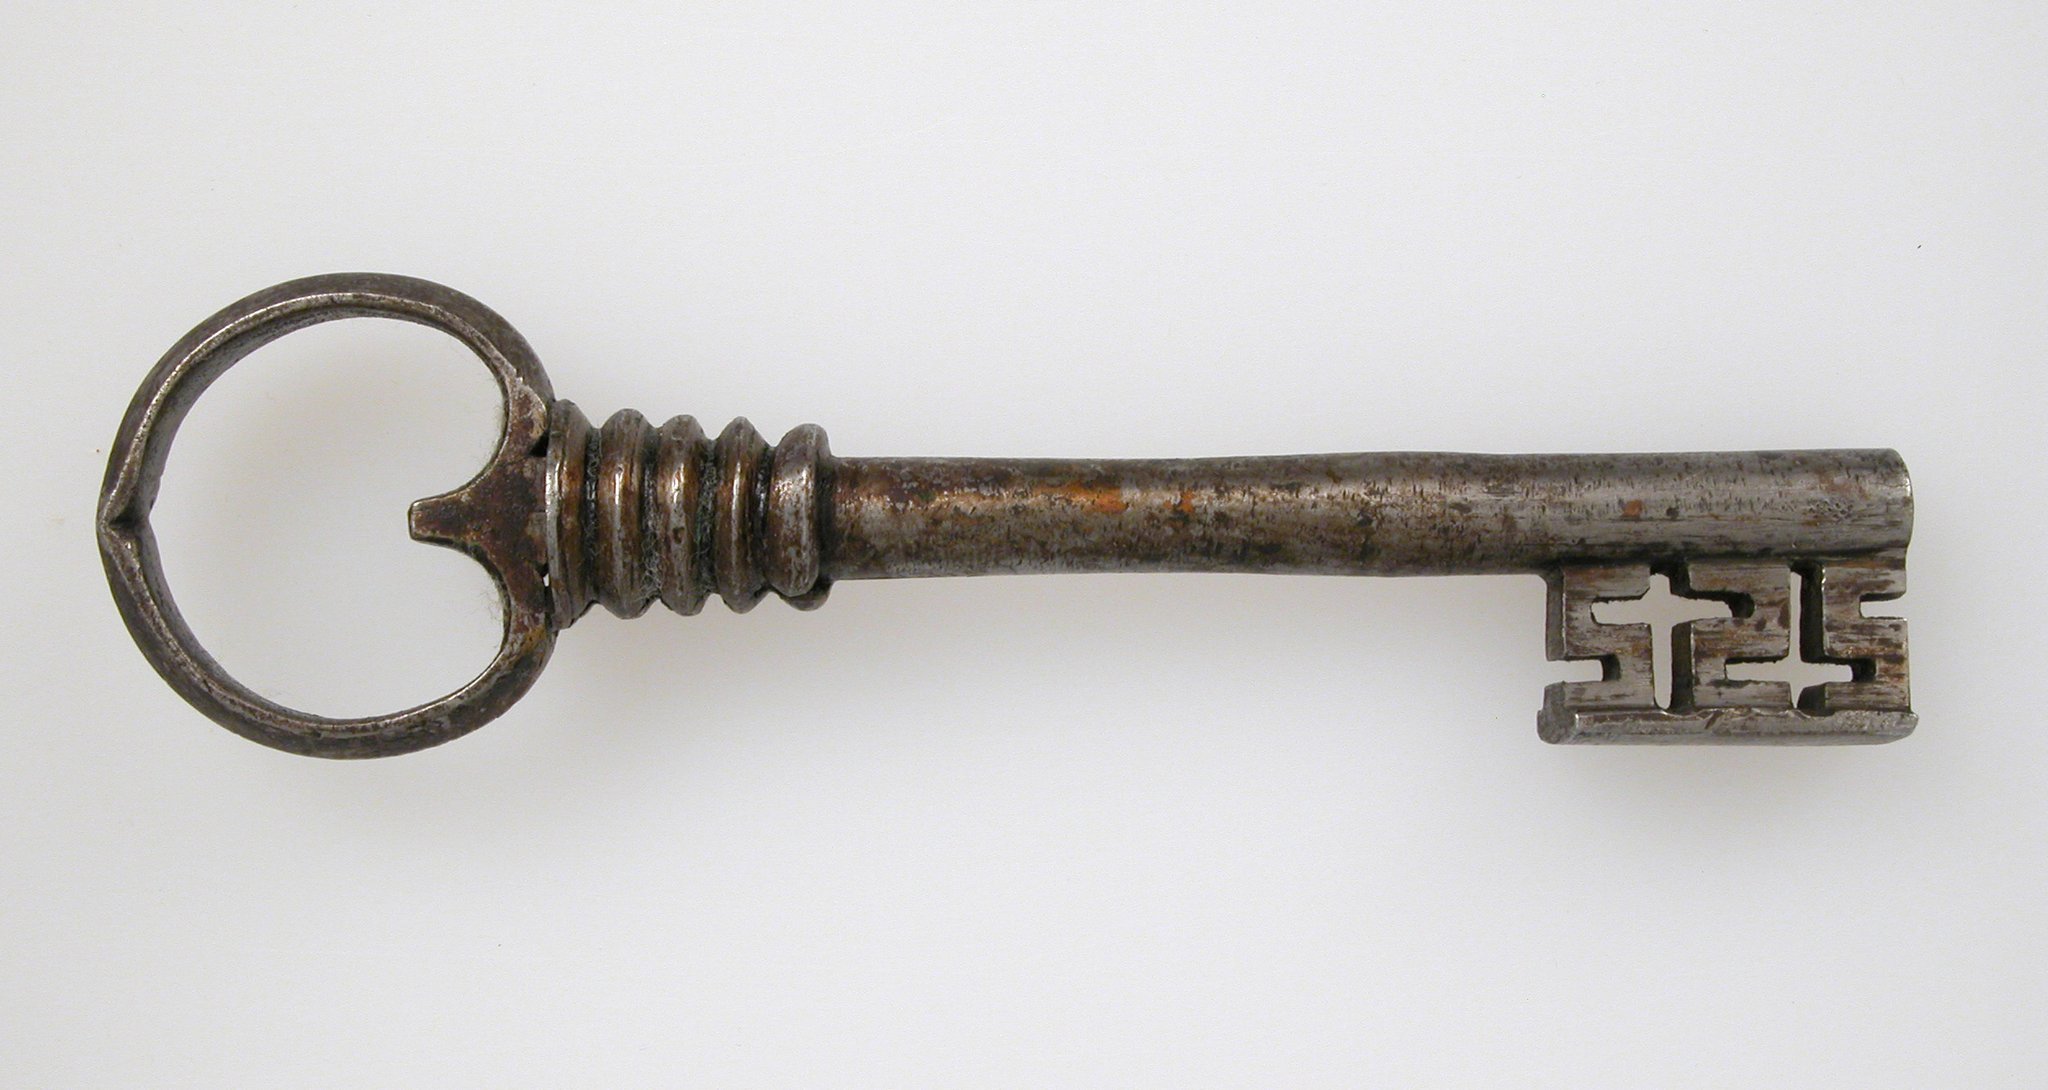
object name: key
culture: german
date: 1401-1500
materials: iron